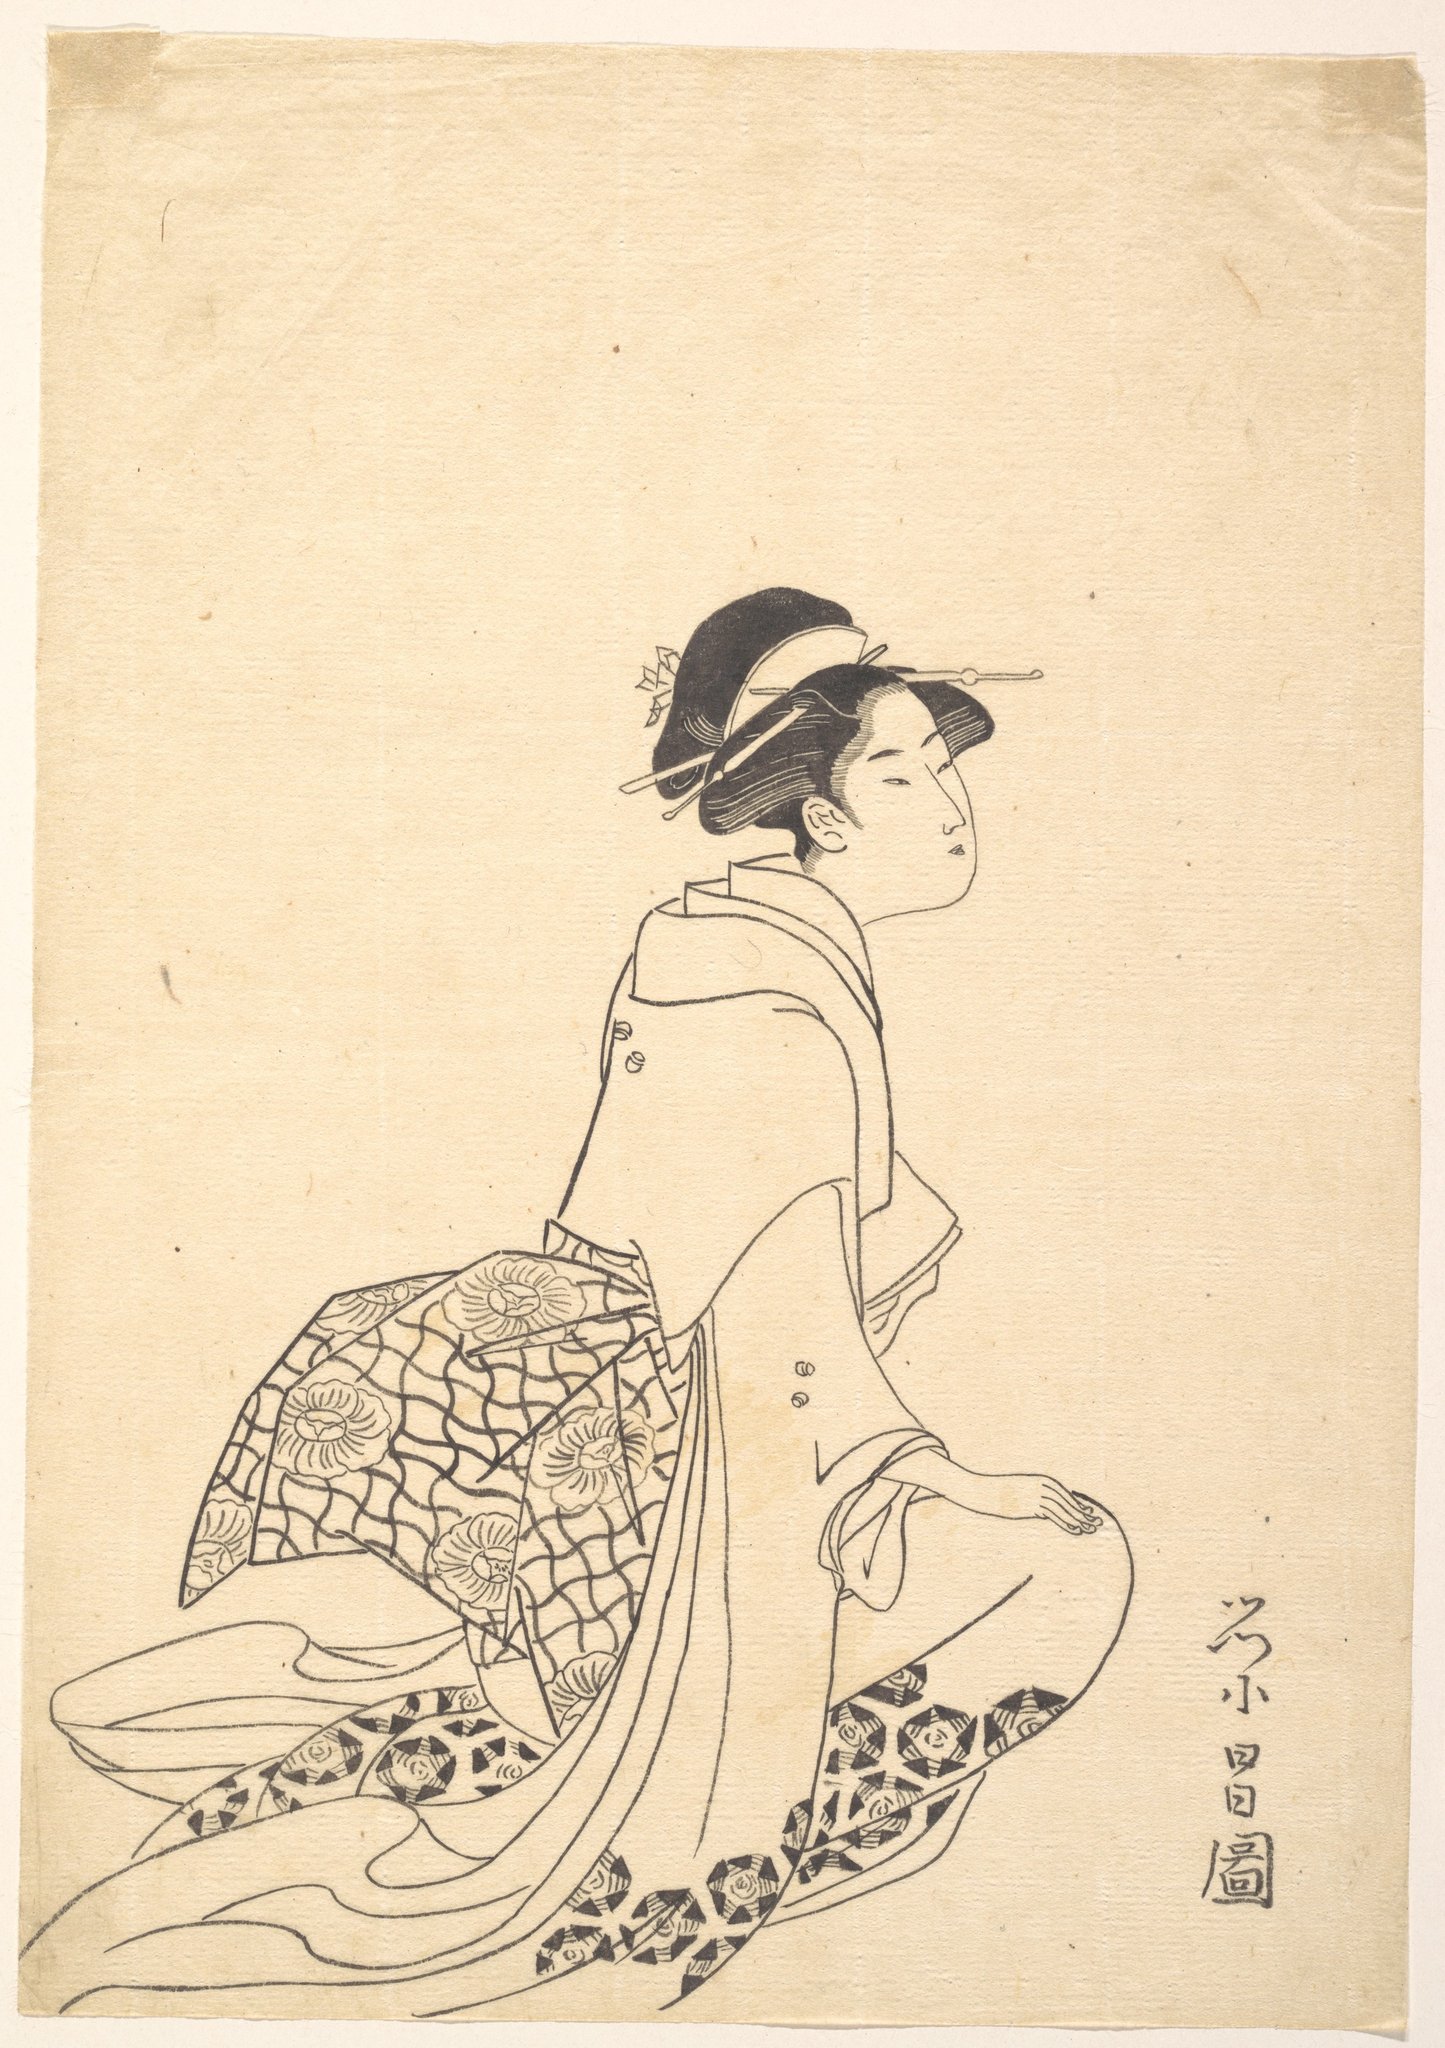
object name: print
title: A Woman Kneeling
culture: japanese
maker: chōkōsai eishō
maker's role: artist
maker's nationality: japanese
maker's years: 1793-1799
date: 1792-1801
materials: ink, paper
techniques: woodblock print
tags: women